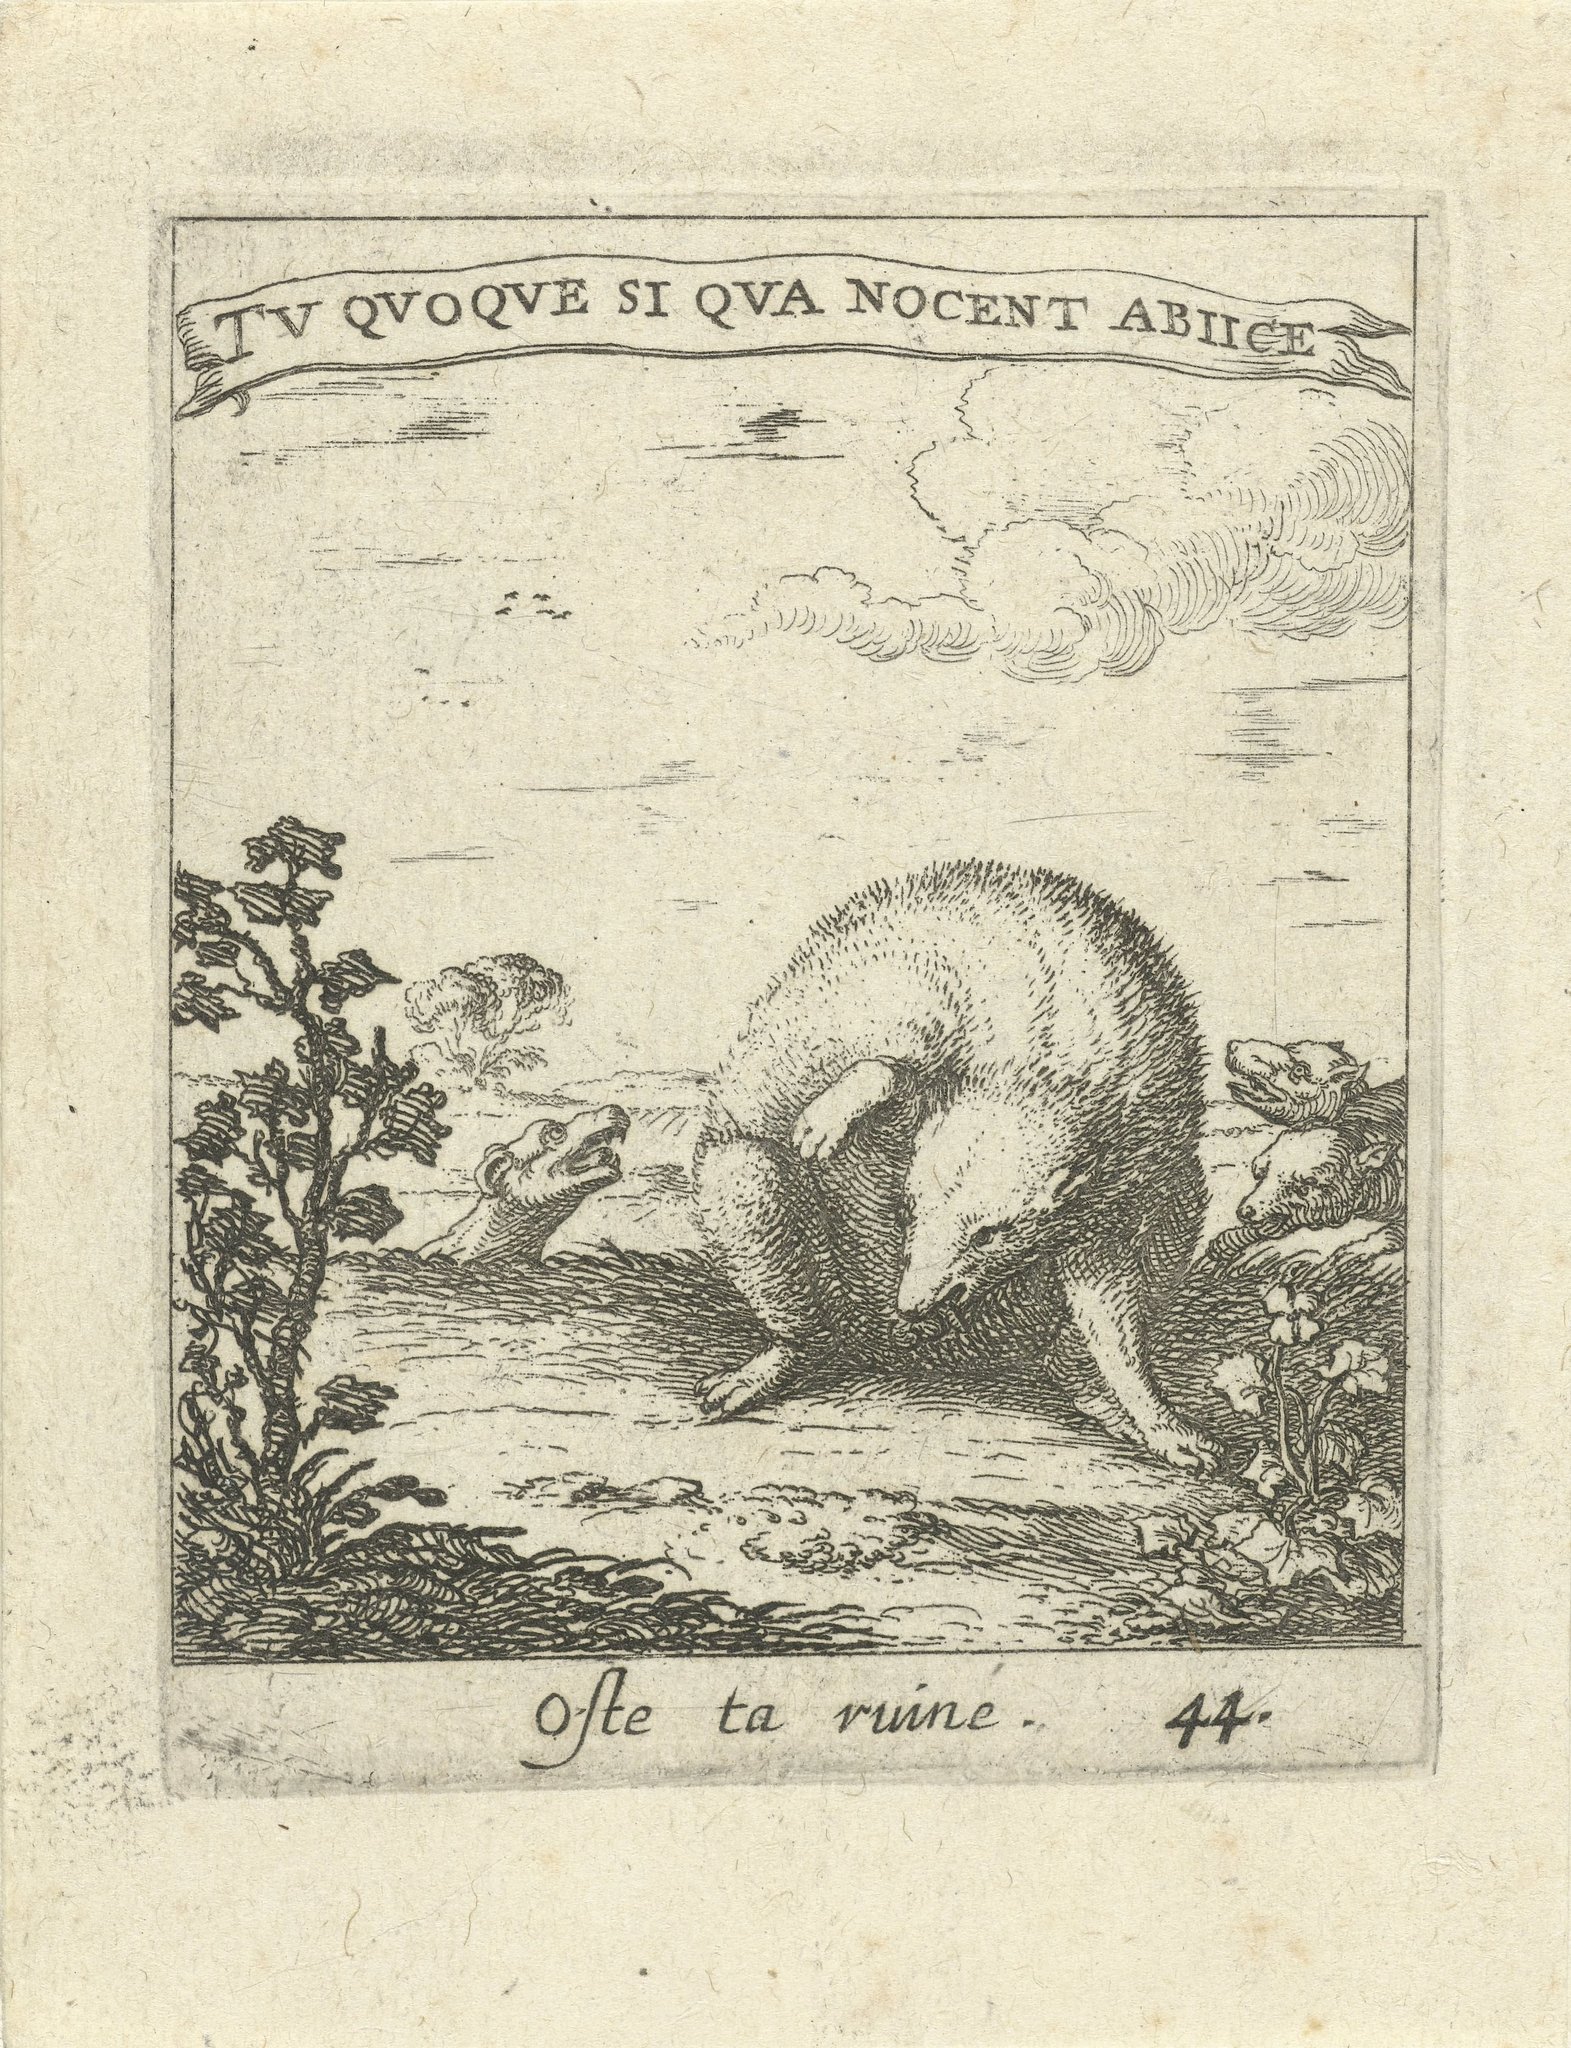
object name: print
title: Devises et emblesmes d'amovr moralisez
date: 1672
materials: paper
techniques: etching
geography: paris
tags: qualities of love: first series (+ emblematical representation of concept)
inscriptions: collector's mark: Lugt 2166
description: Een landschap met op de voorgrond een das en op de achtergrond huilende wolven. Op een banderol een devies in Latijn en een onderschrift in Frans, beide over de liefde.